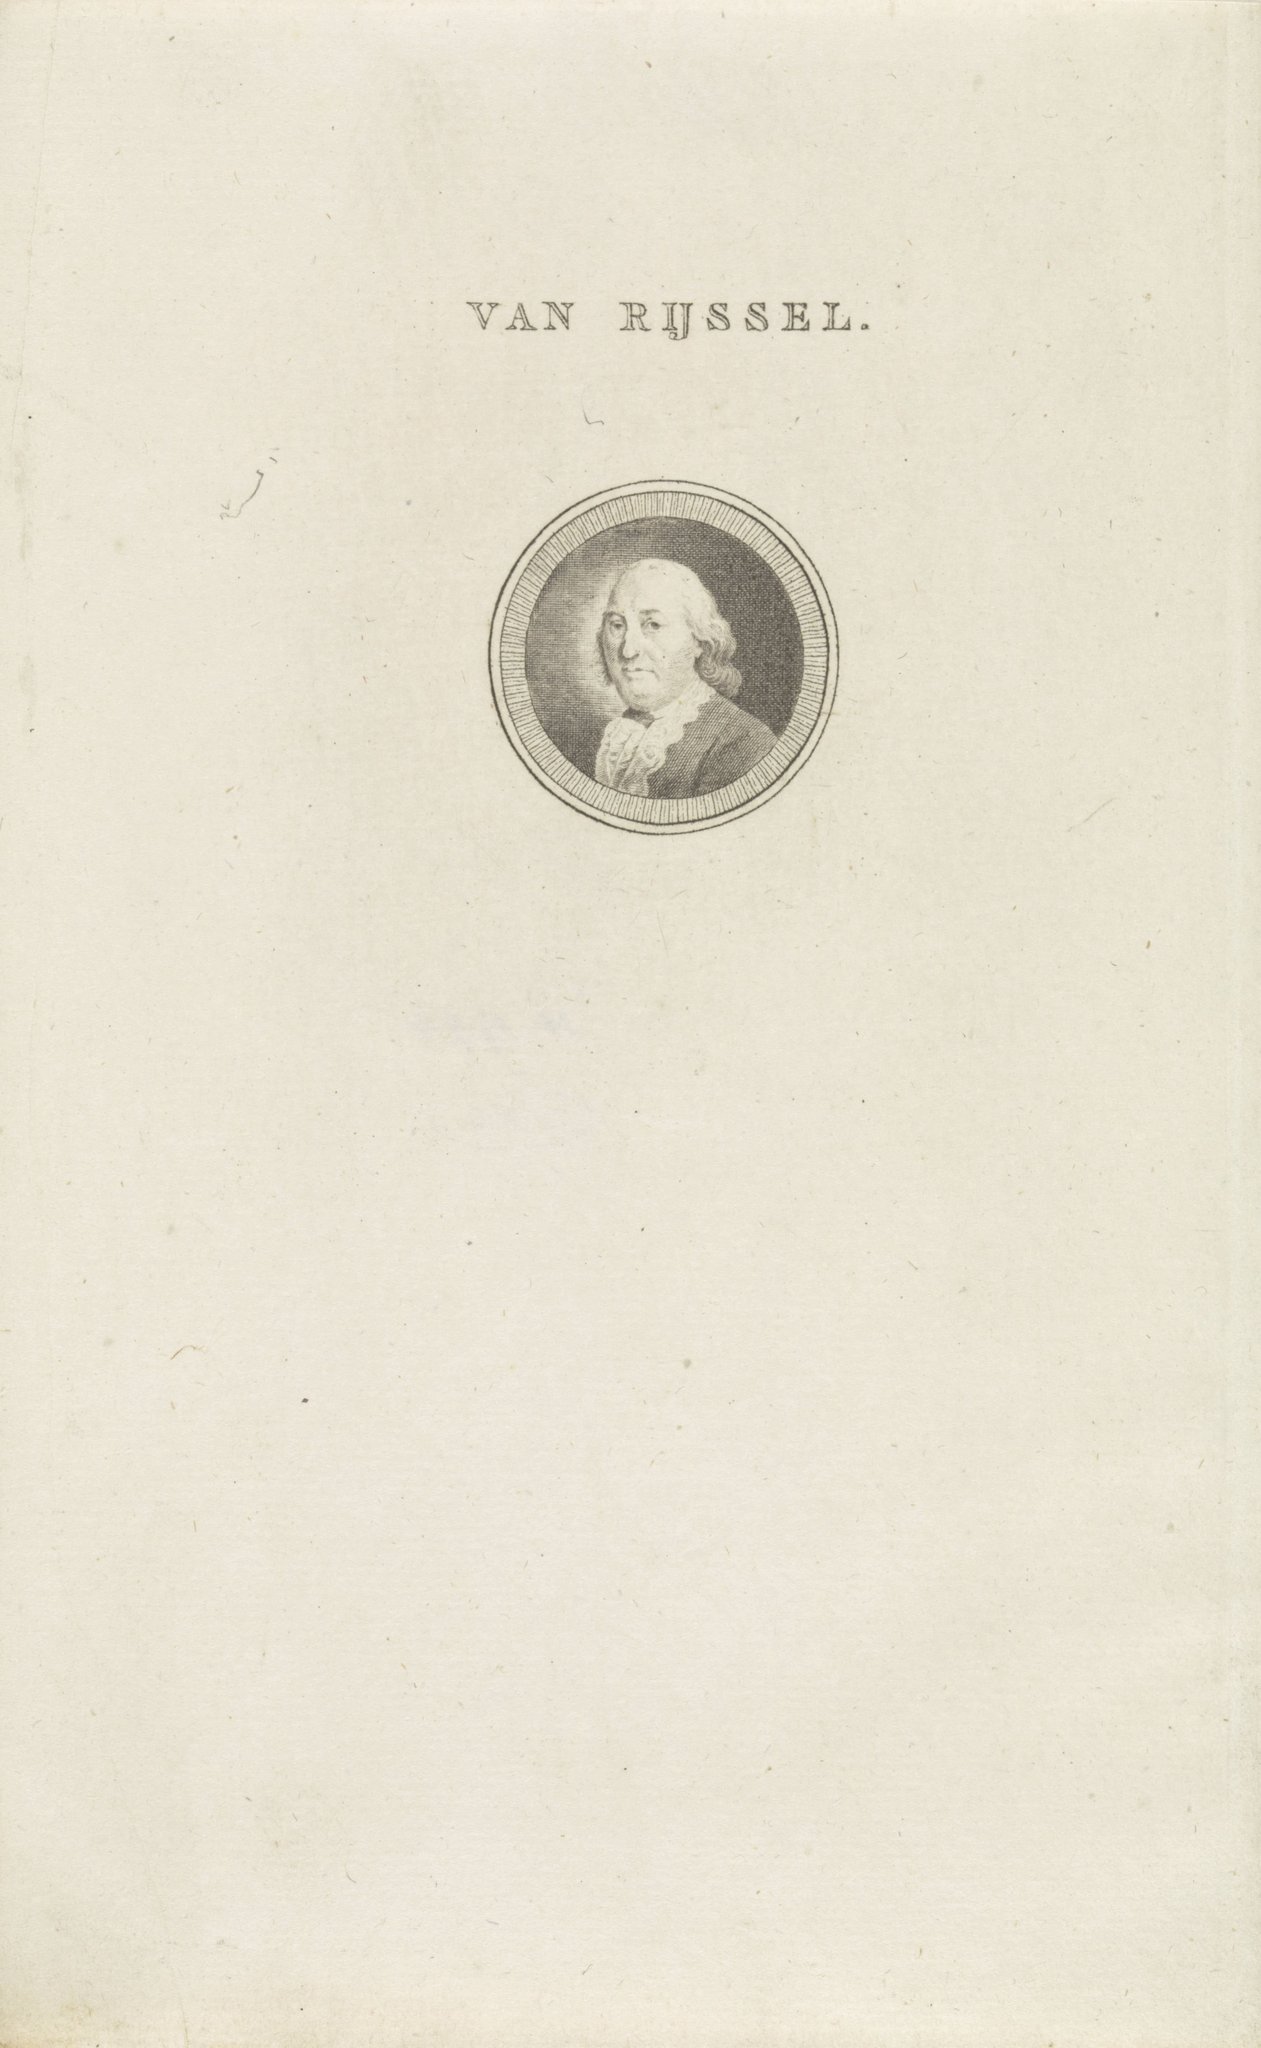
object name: print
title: Vaderlandsche Chocolaad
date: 1787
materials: paper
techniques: engraving, etching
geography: amsterdam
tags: generaal-majoor, albert van ryssel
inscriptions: collector's mark: Lugt 2228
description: Jacobus Wijsman heeft sommige platen van de serie patriottenportretten van Abraham Jacobsz. Hulk aangepast en hergebruikt in zijn eigen serie patriottenportretten. Prent maakt deel uit van een serie, die in drie afleveringen werd uitgegeven onder de titel: Verzameling van Afbeeldingen van Nederlandsche Mannen, beroemd geworden, wegens hunne Moed en Burgerliefde in de jongstledene Beroerten. 1794-1795. Zie Atlas van Stolk.